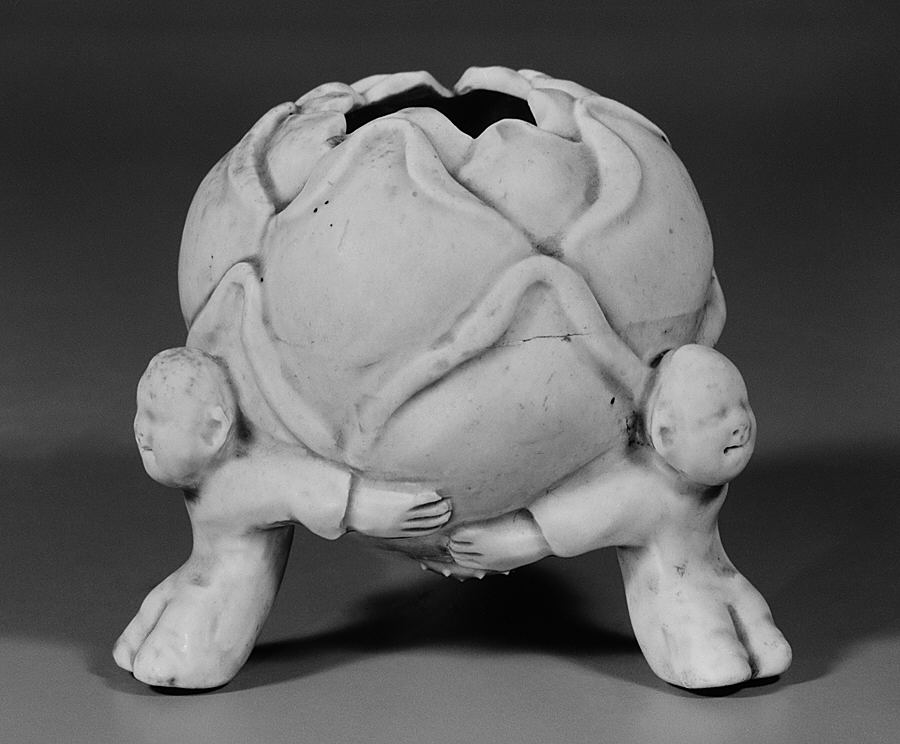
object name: water pot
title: Water pot with three boys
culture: chinese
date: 1801-1900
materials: glaze, porcelain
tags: boys